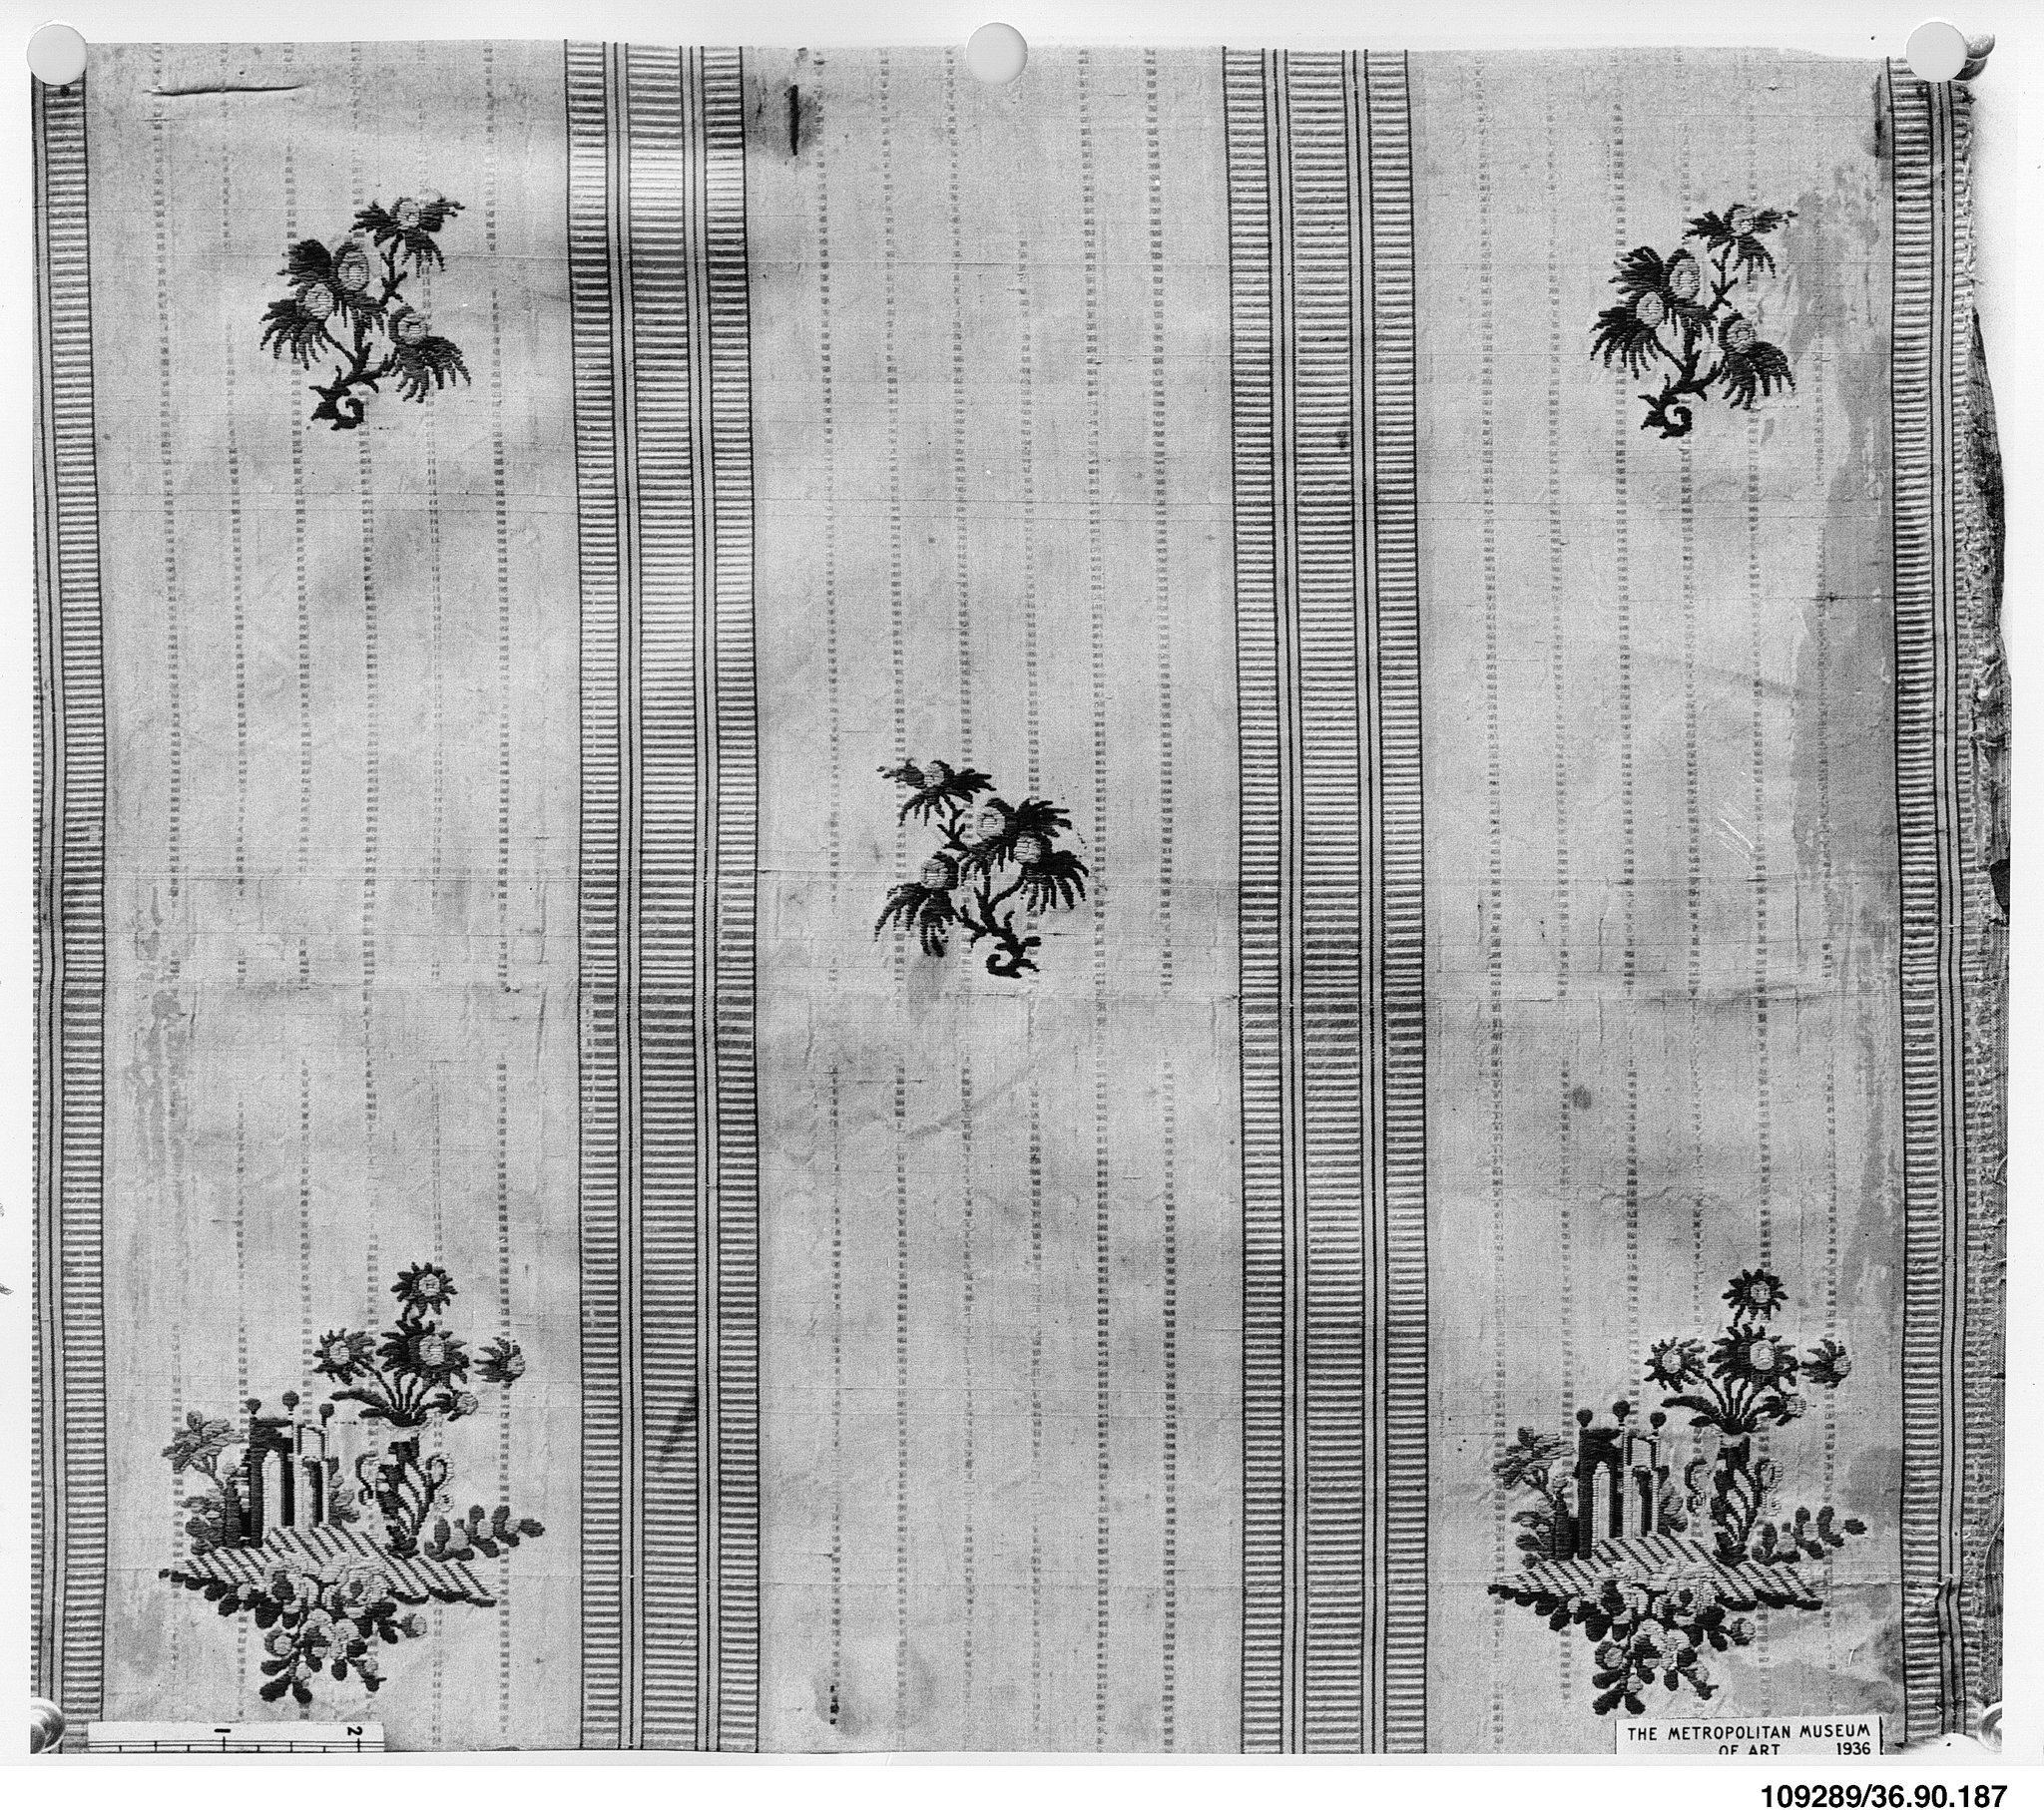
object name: piece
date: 1701-1800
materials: silk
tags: flowers